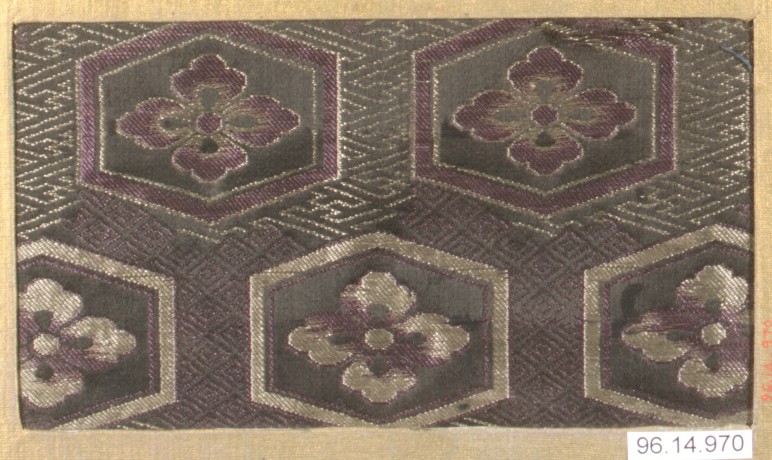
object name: piece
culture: japanese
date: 1701-1900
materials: silk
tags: flowers